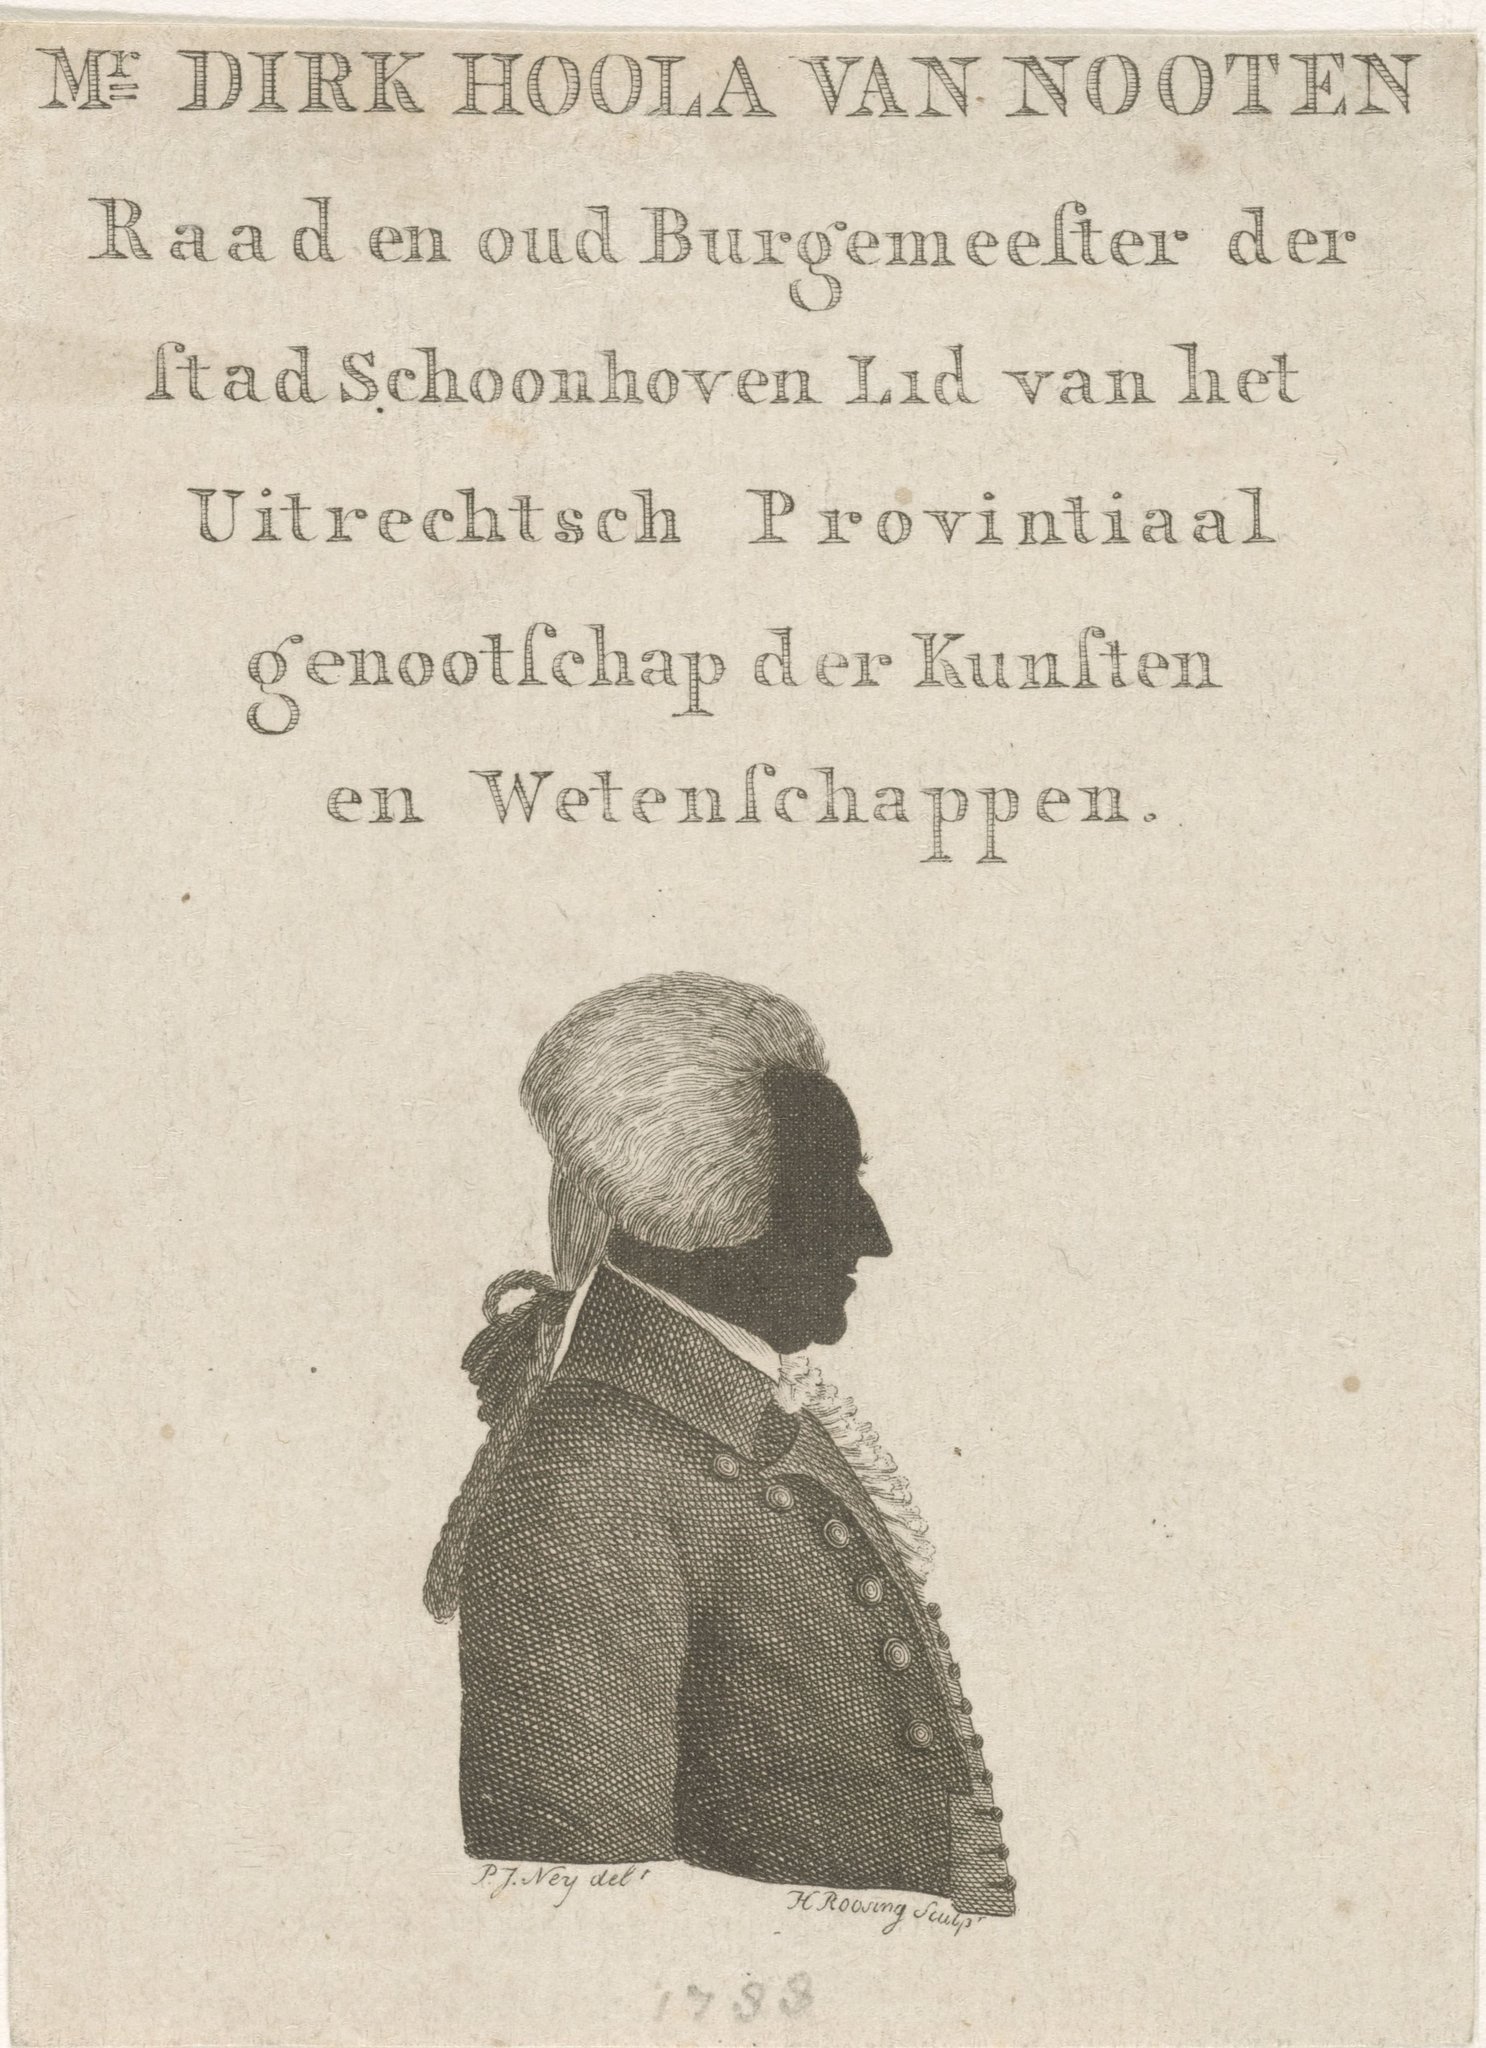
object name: print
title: Portret van Dirk Hoola van Nooten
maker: hendrik roosing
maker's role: print maker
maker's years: 1763-1826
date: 1788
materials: paper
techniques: engraving, etching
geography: rotterdam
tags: dirk hoola van nooten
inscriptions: inscription: ‘1788’, collector's mark: Lugt 2228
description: Portret van Dirk Hoola van Nooten, burgemeester van Schoonhoven.